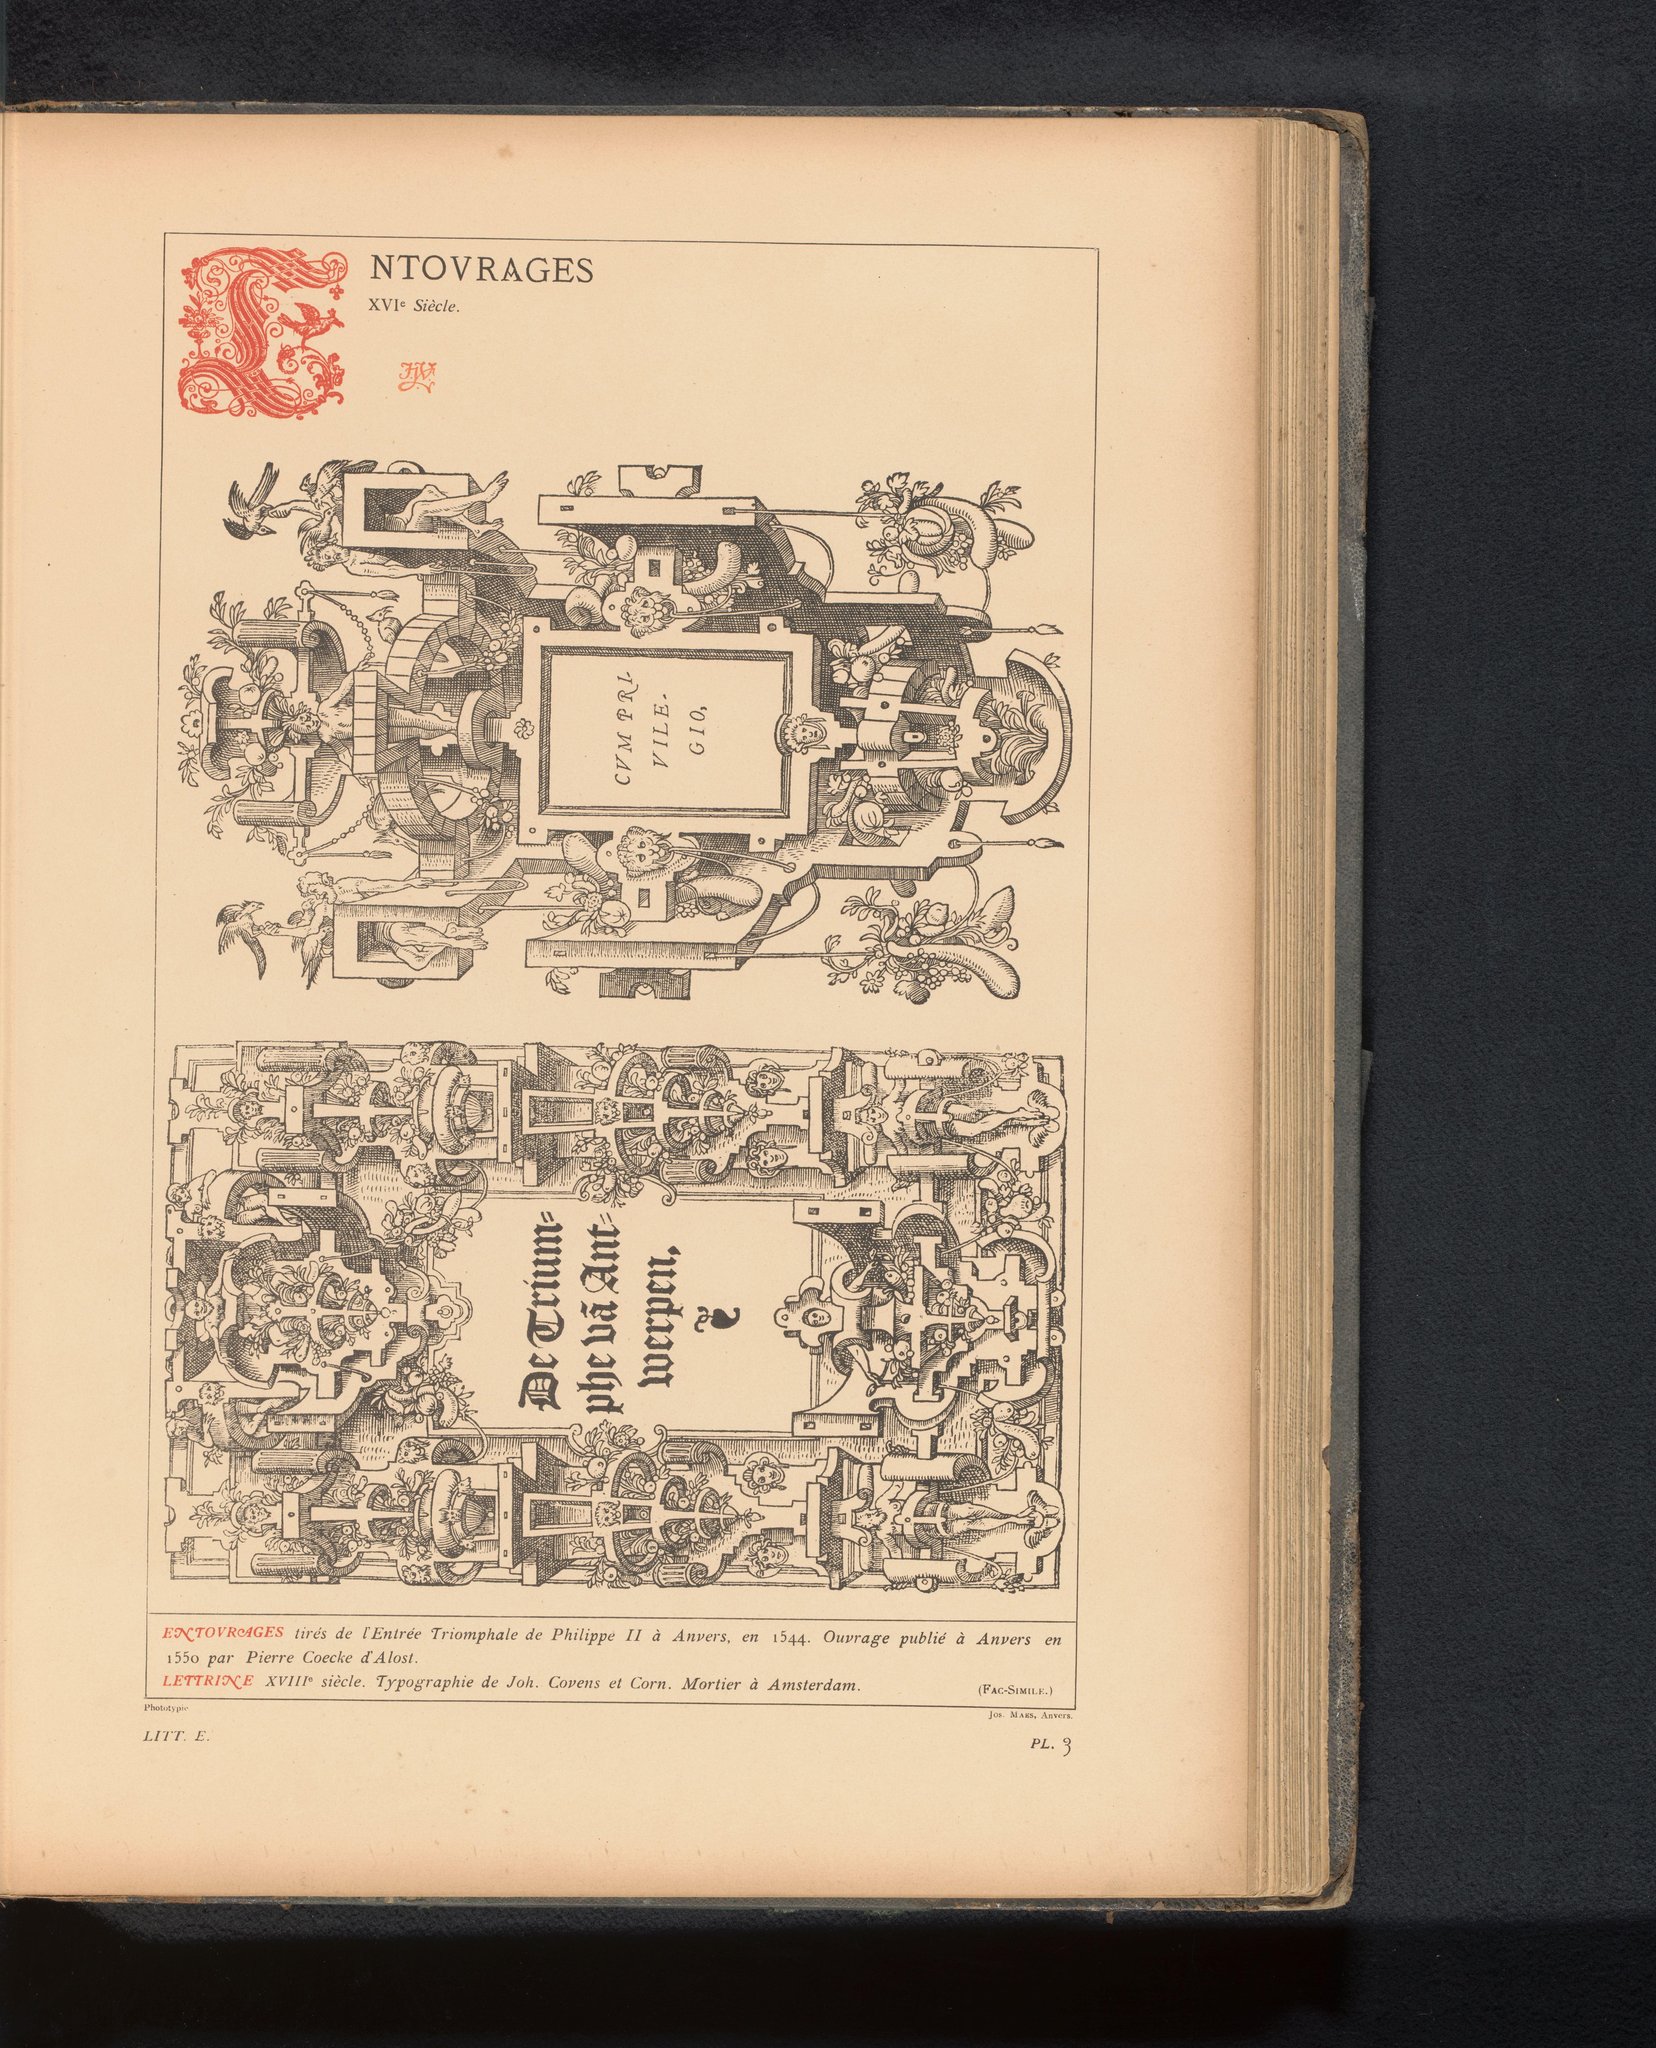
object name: page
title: Reproductie van een prent van twee cartouches van titelpagina's, uitgegeven door Pieter Coecke van Aelst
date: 1875-1880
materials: paper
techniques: photolithography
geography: antwerp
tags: title-page, ornament ~ cartouche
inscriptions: monogram: ‘JJvY’, inscription: ‘ENTOURAGES tirés de (...)’, inscription: ‘LITT. E. - PL. 3’